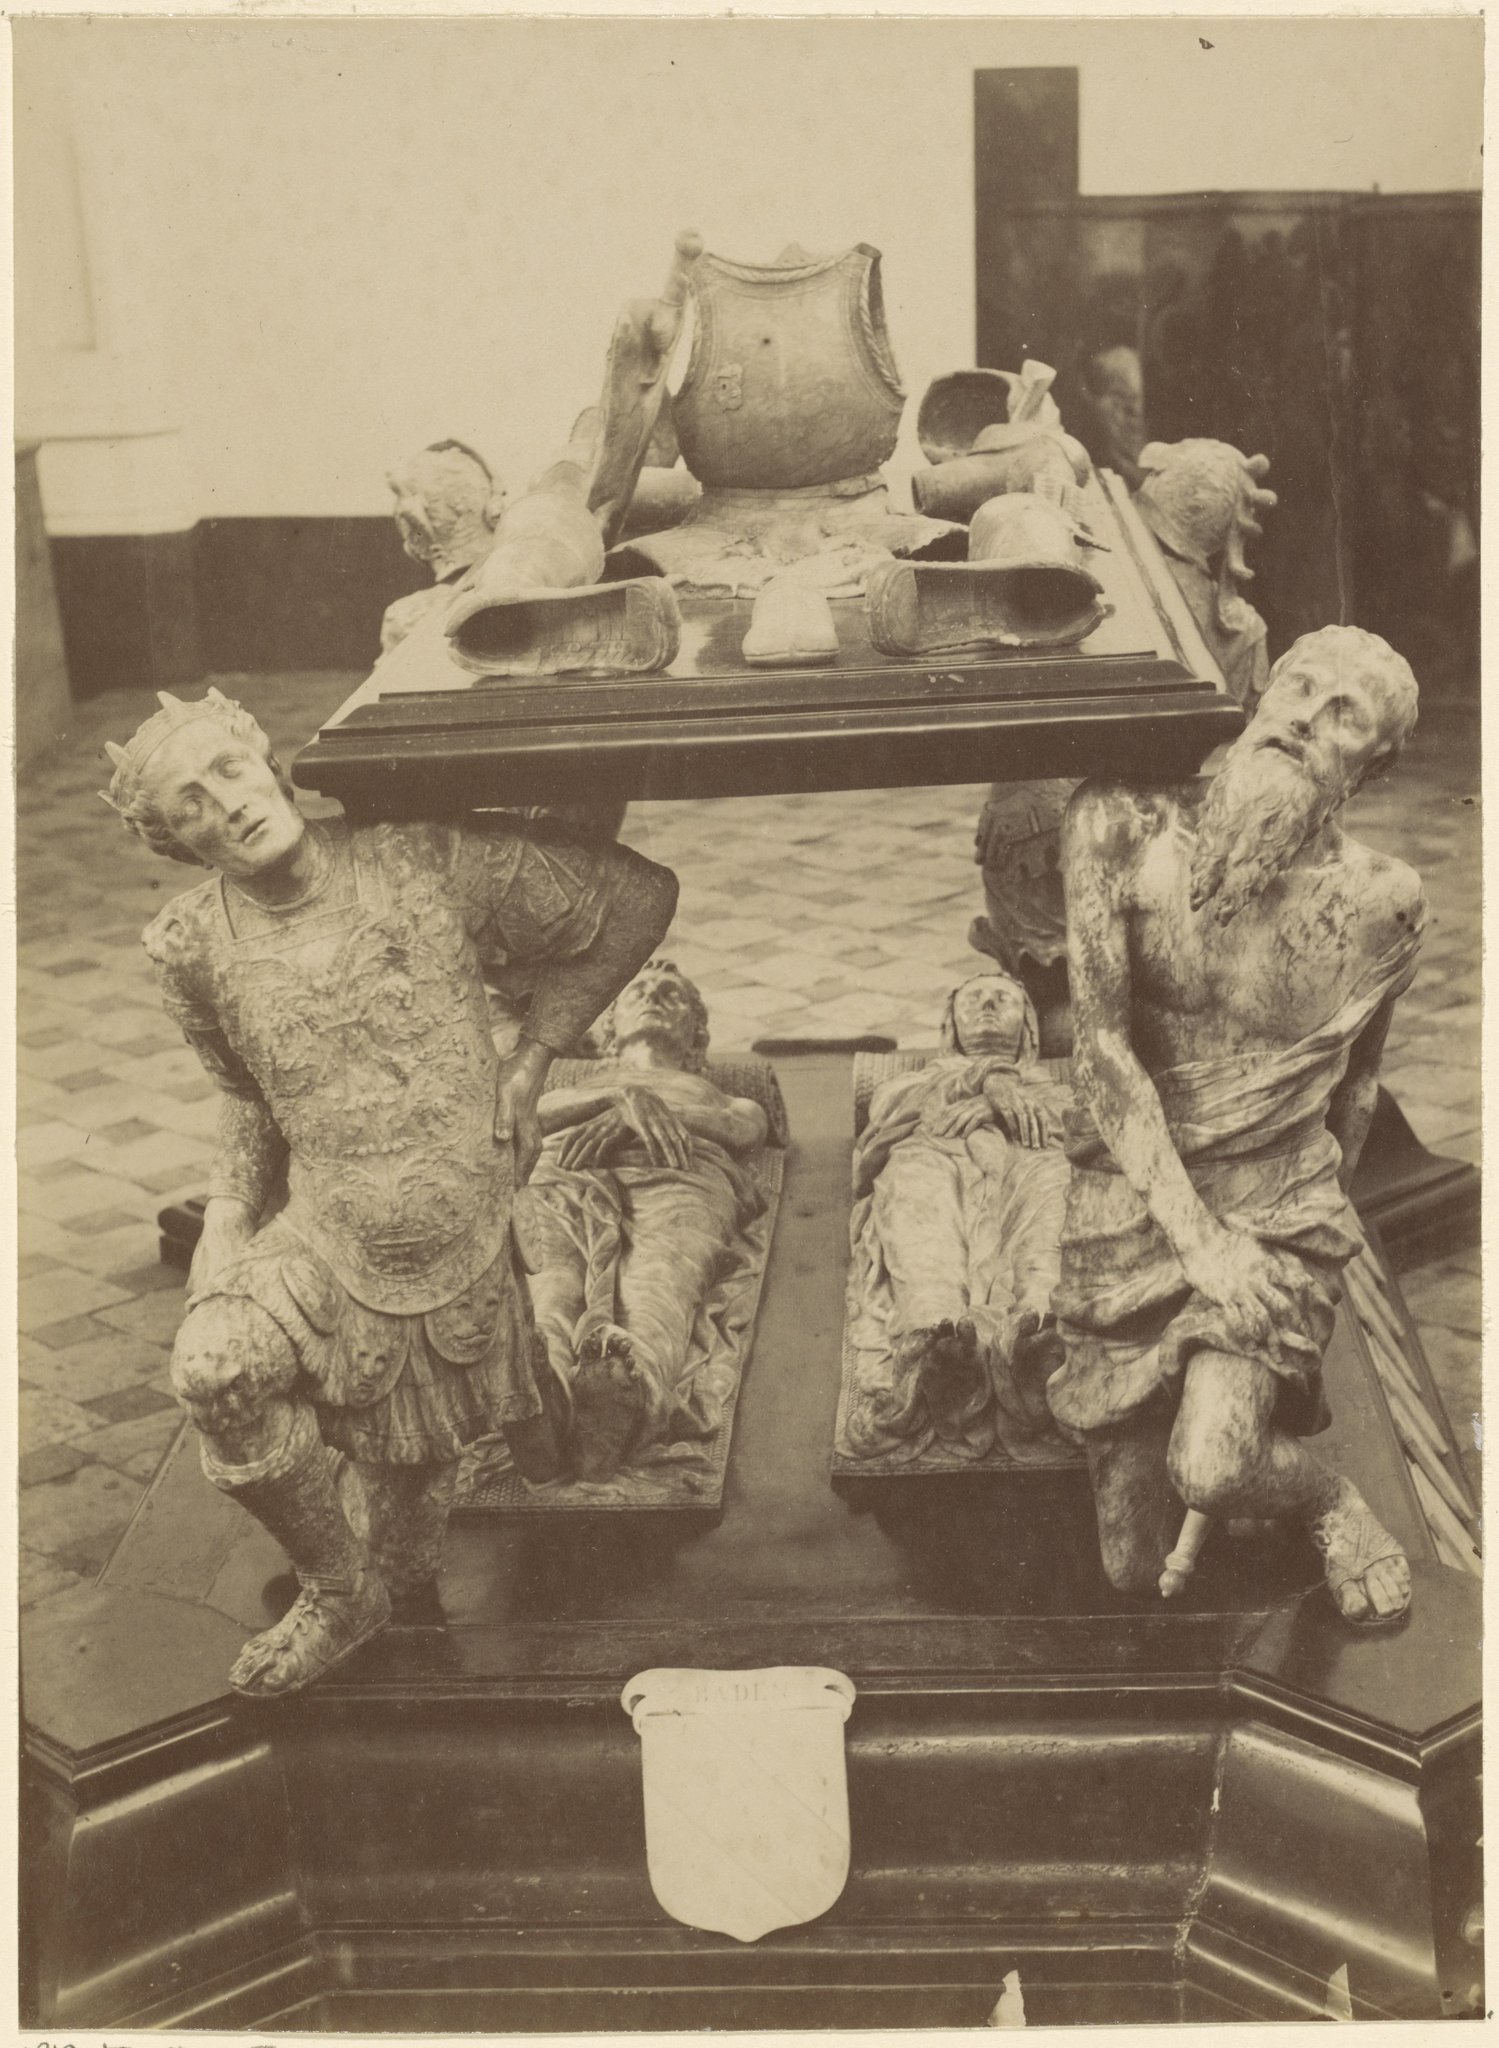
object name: photograph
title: Grafmonument voor Engelbrecht II, graaf van Nassau-Dillenburg-Breda, 1504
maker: Anonymous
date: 1850-1930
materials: photographic support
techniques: photography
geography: netherlands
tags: brussels, interior of church, grave-building, monumental tomb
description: De hier vermelde titel verwijst naar de hoogst verkregen titel van de geportretteerde, niet per se naar de titel die de geportretteerde op deze voorstelling draagt.